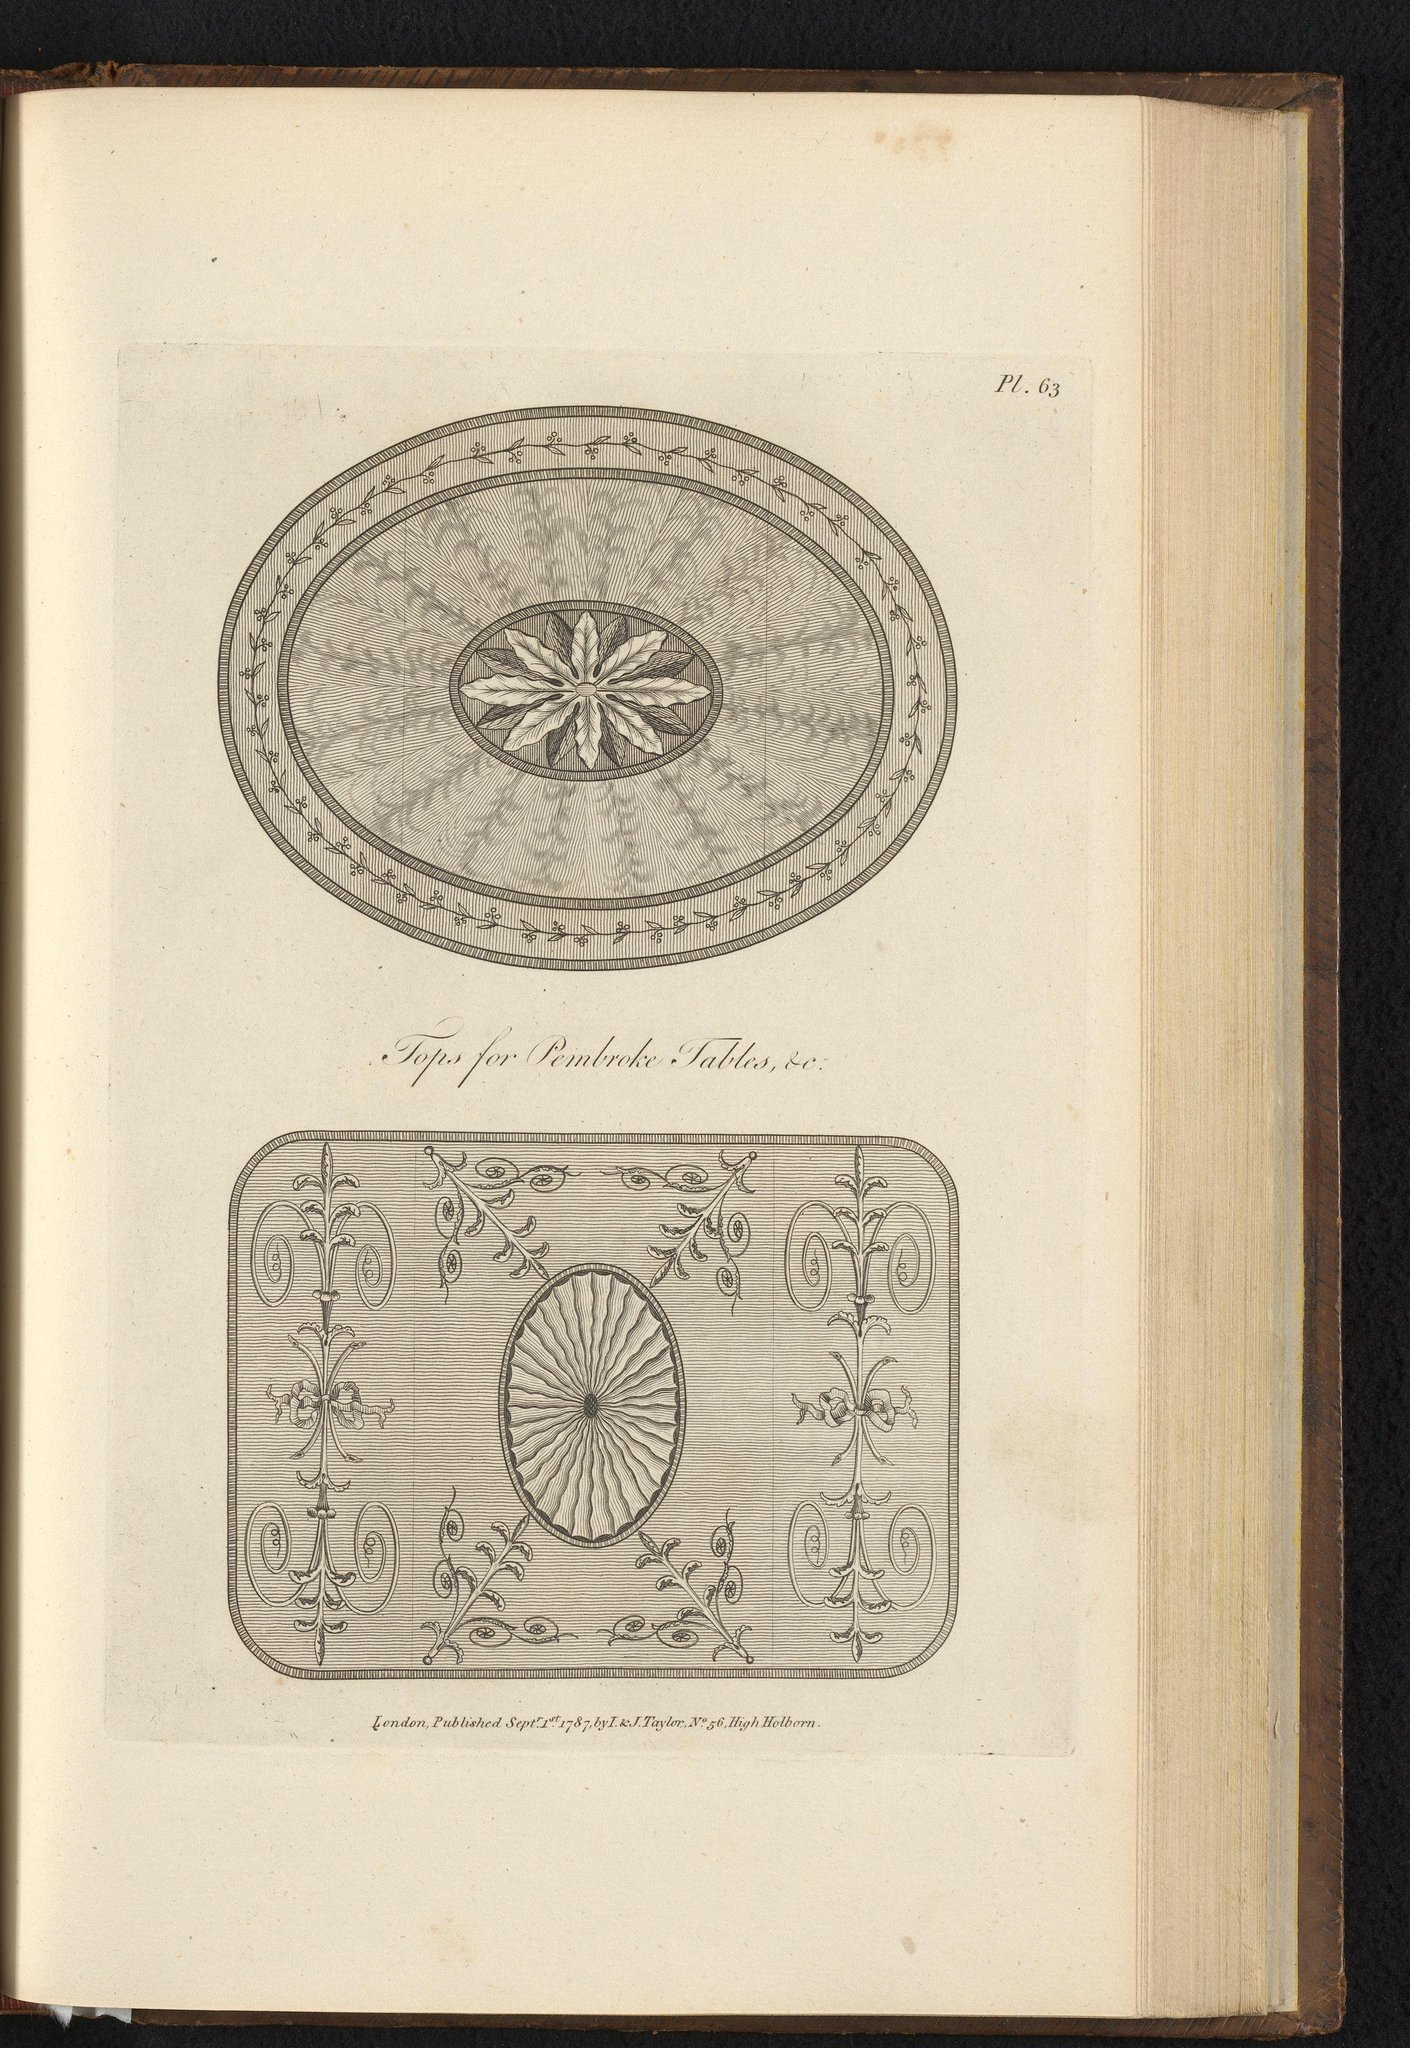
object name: print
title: Bovenaanzichten van twee tafels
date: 1787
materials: paper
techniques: engraving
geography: holborn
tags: table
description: Genummerd: Pl. 63. Prent maakt deel uit van een boek.